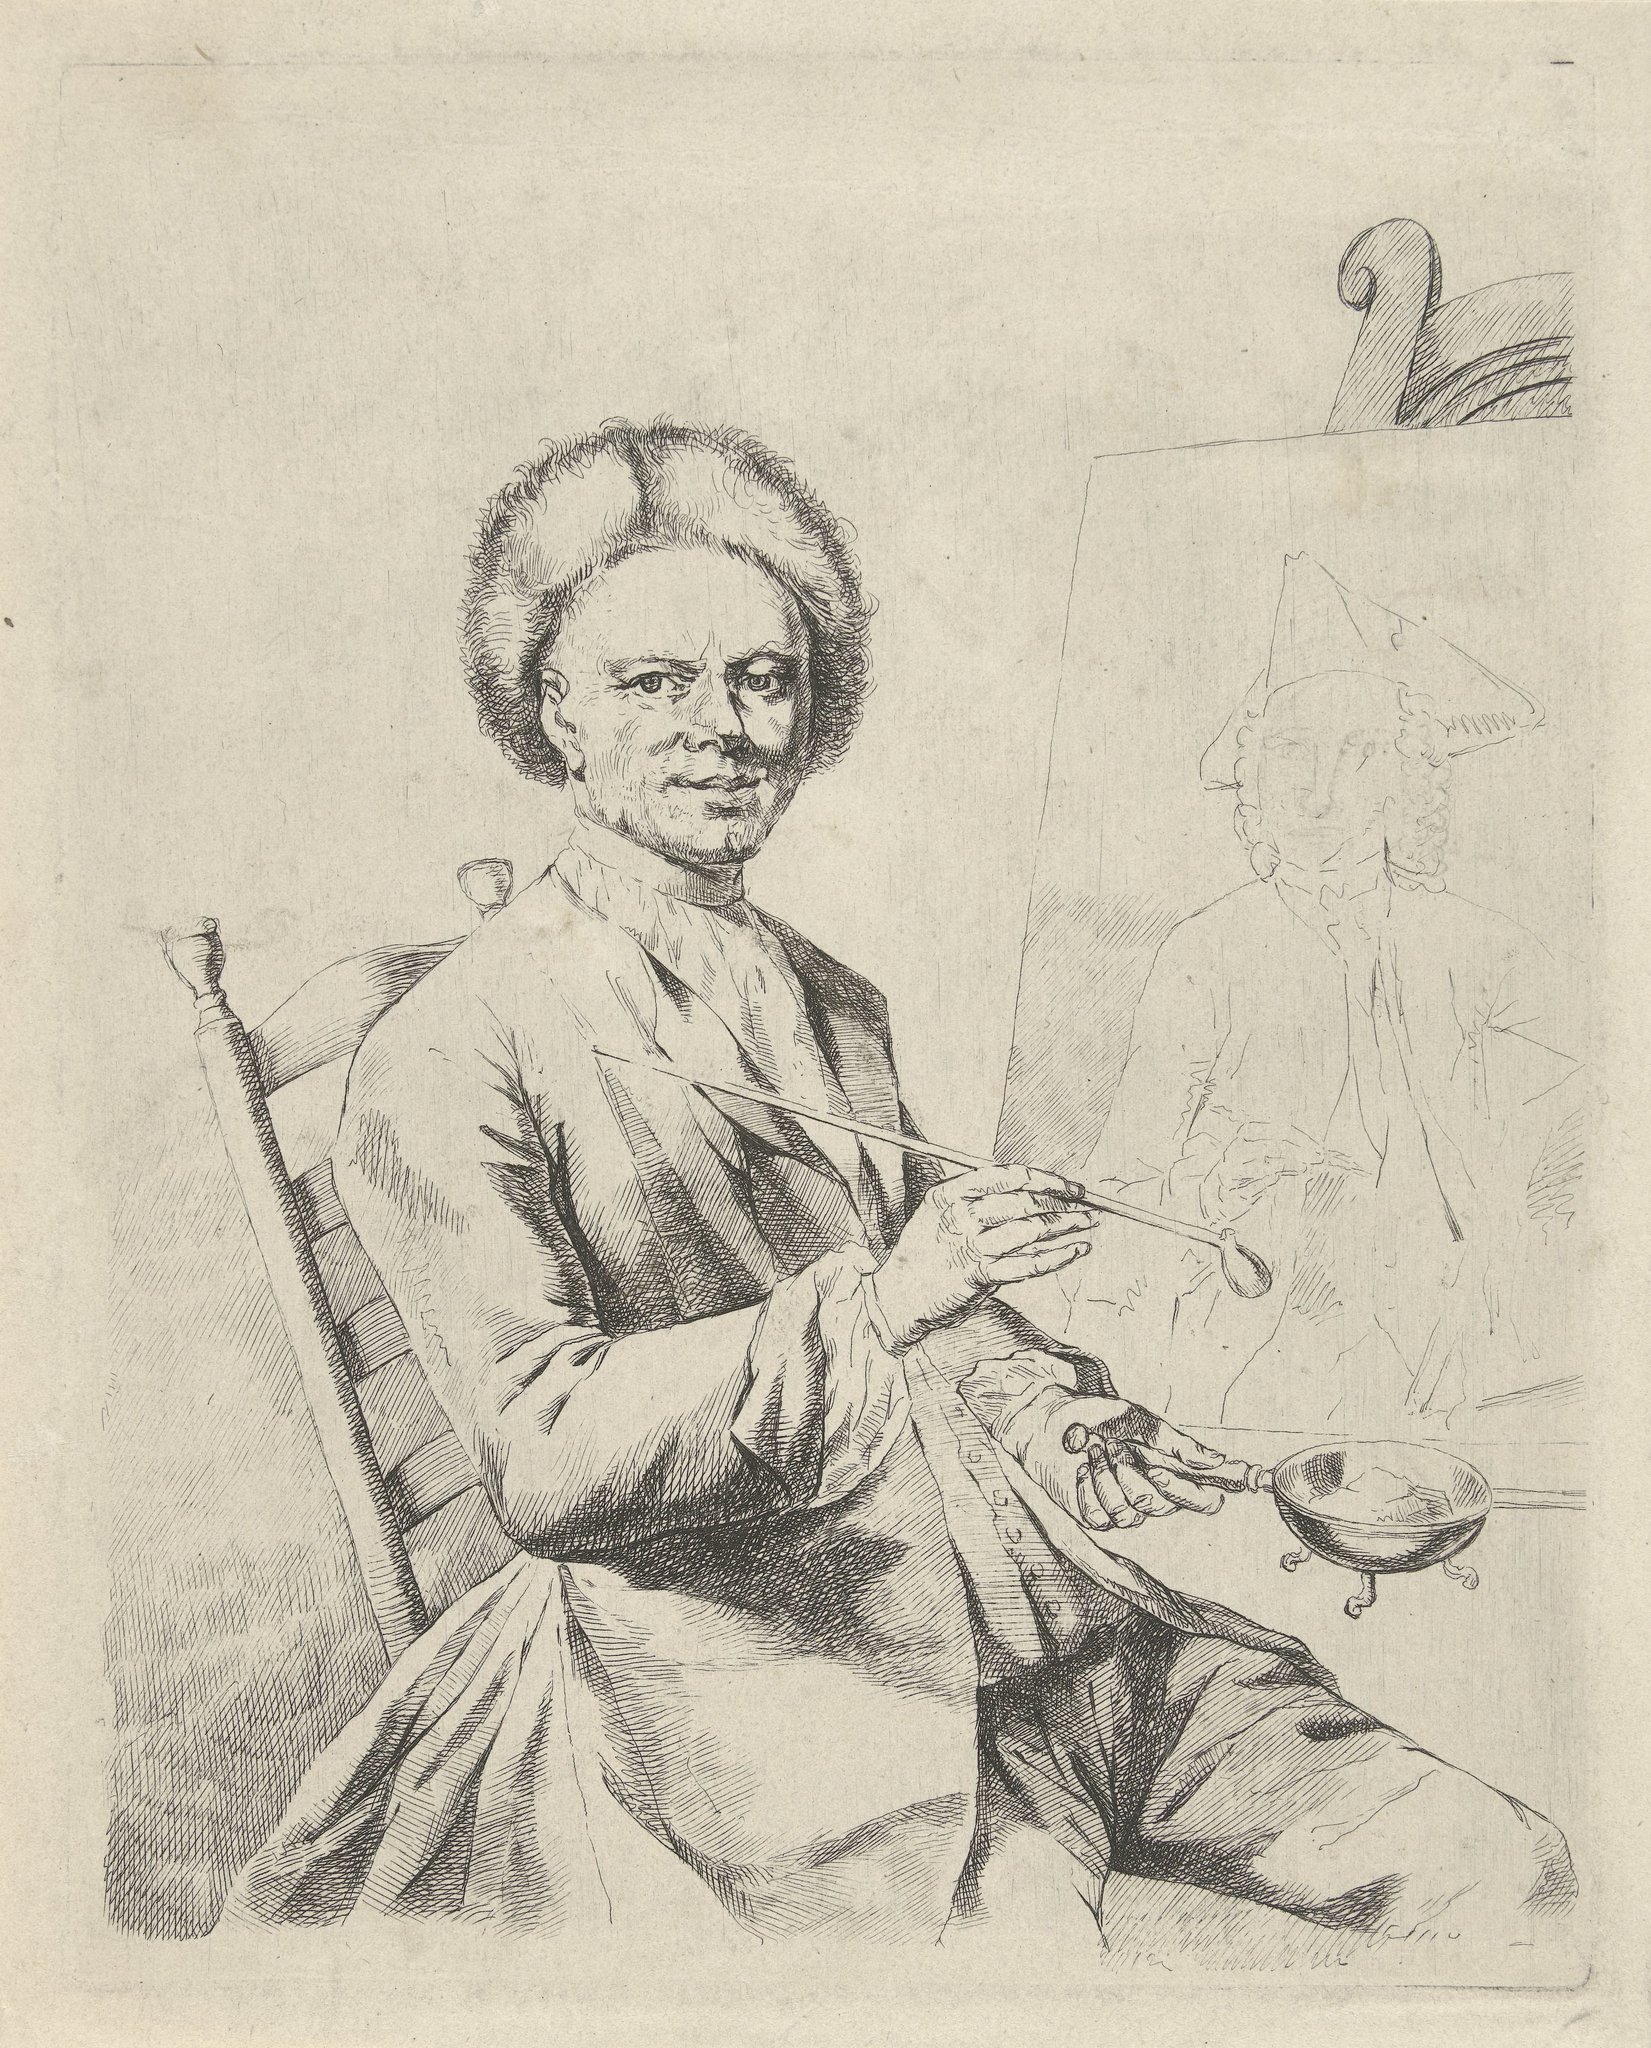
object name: print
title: Portret van Jan Maurits Quinkhart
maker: julius henricus quinkhard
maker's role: draughtsman, painter, print maker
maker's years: 1734-1795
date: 1756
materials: paper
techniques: etching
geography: amsterdam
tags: amsterdam, painter, draughtsman, jan maurits quinkhard, head-gear: cap (+ men's clothes), pipe ~ tobacco, painter at work, in his studio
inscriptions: collector's mark: Lugt 2228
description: Portret van de Amsterdamse kunstschilder Jan Maurits Quinkhart. Hij zit in zijn atelier voor een schildersezel met daarop een schilderij, een pijp te roken. Hij draagt een bontmuts op het hoofd.